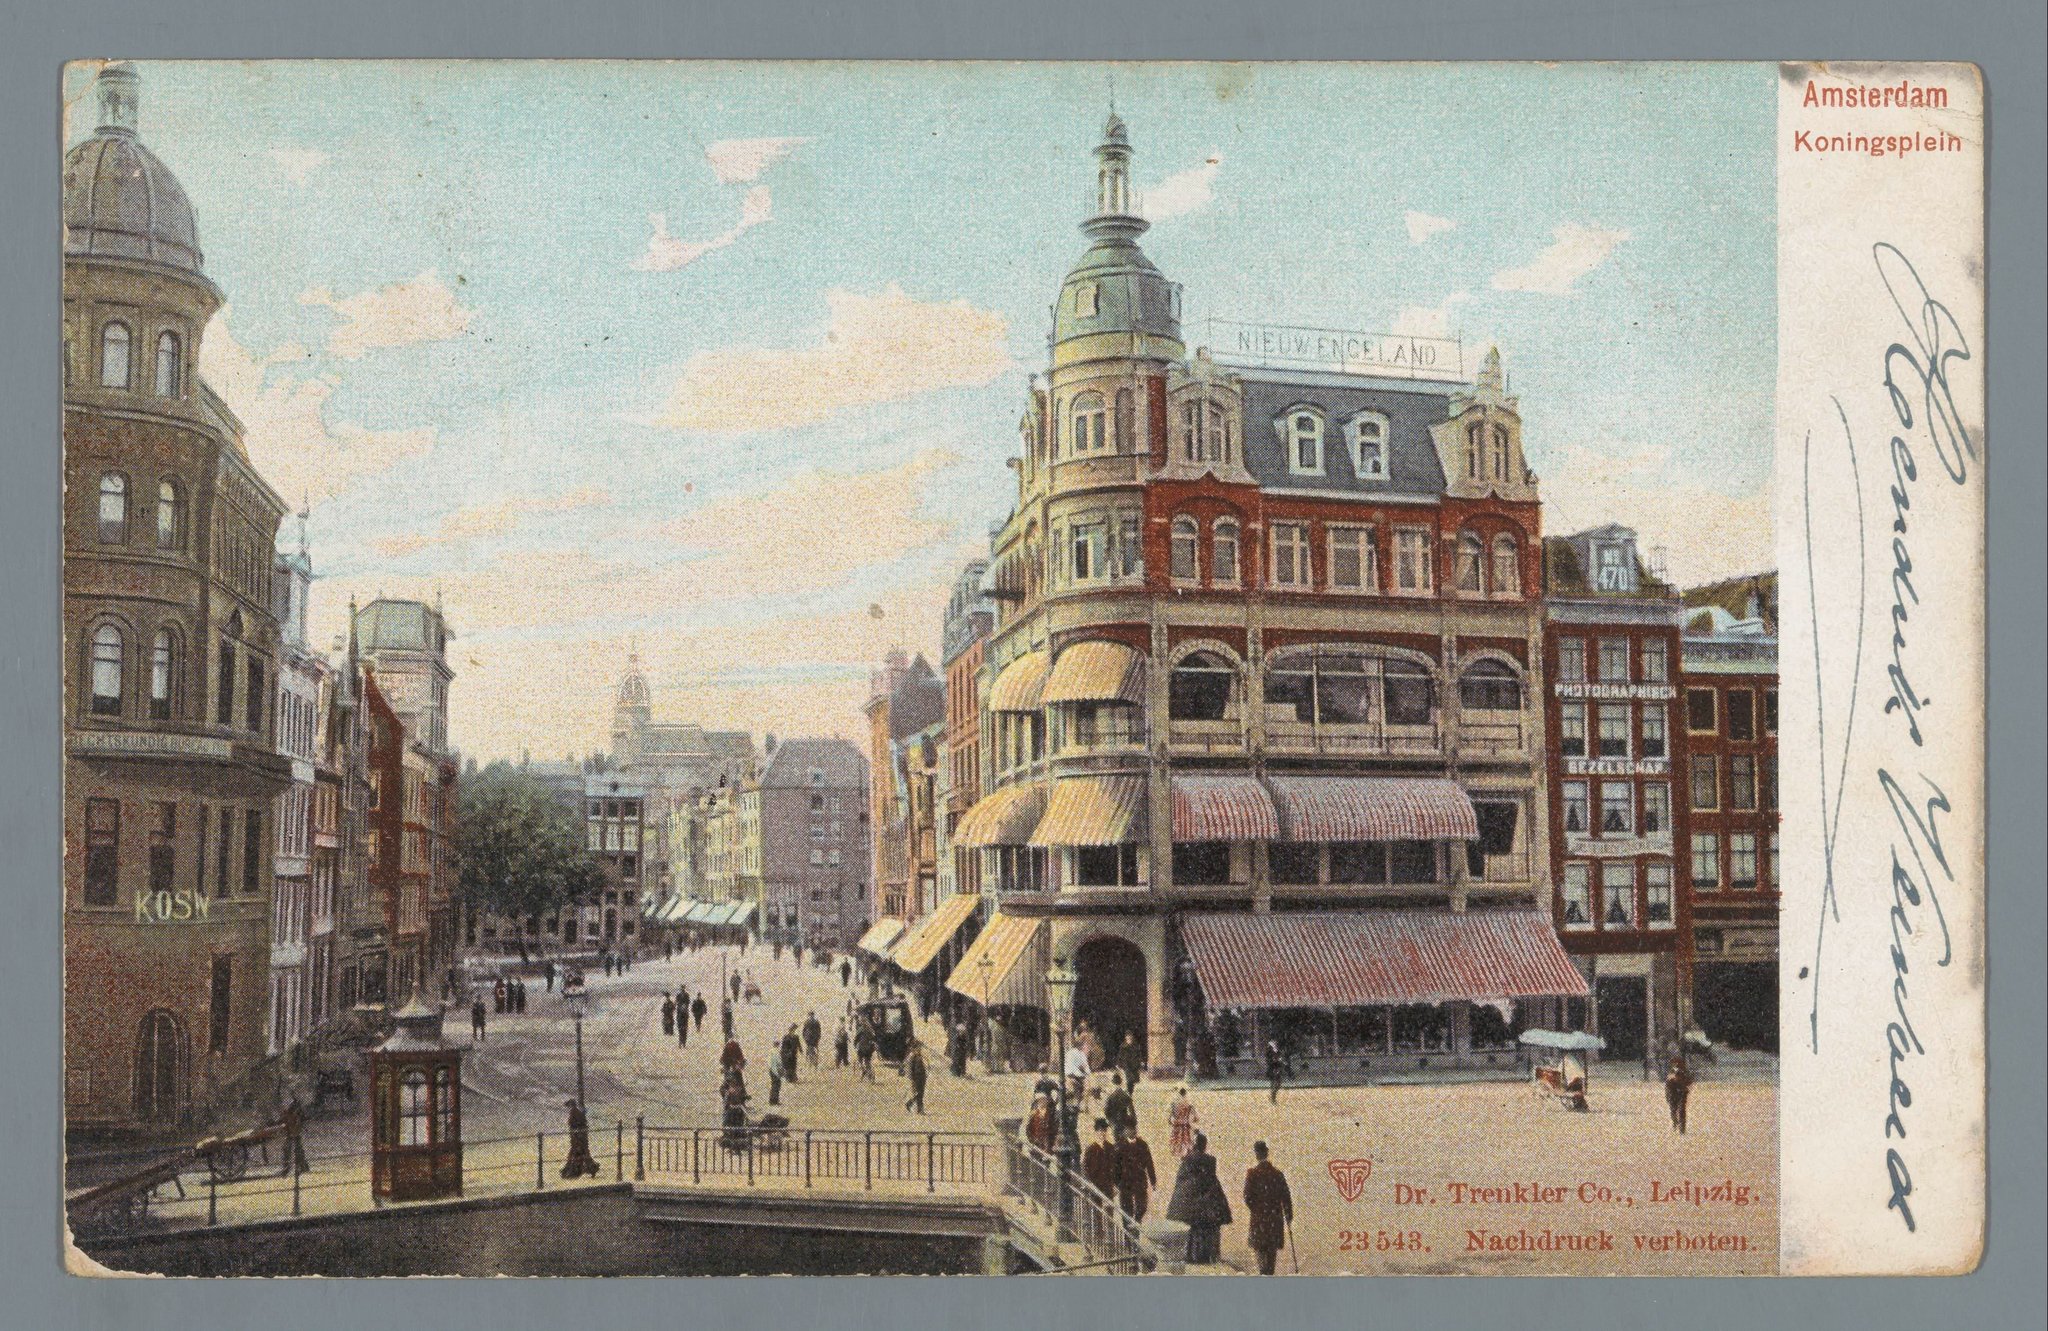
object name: photomechanical print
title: Amsterdam, Koningsplein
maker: Anonymous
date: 1890-1920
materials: cardboard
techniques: writing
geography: leipzig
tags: square, place, circus, etc., city-view in general; 'veduta'